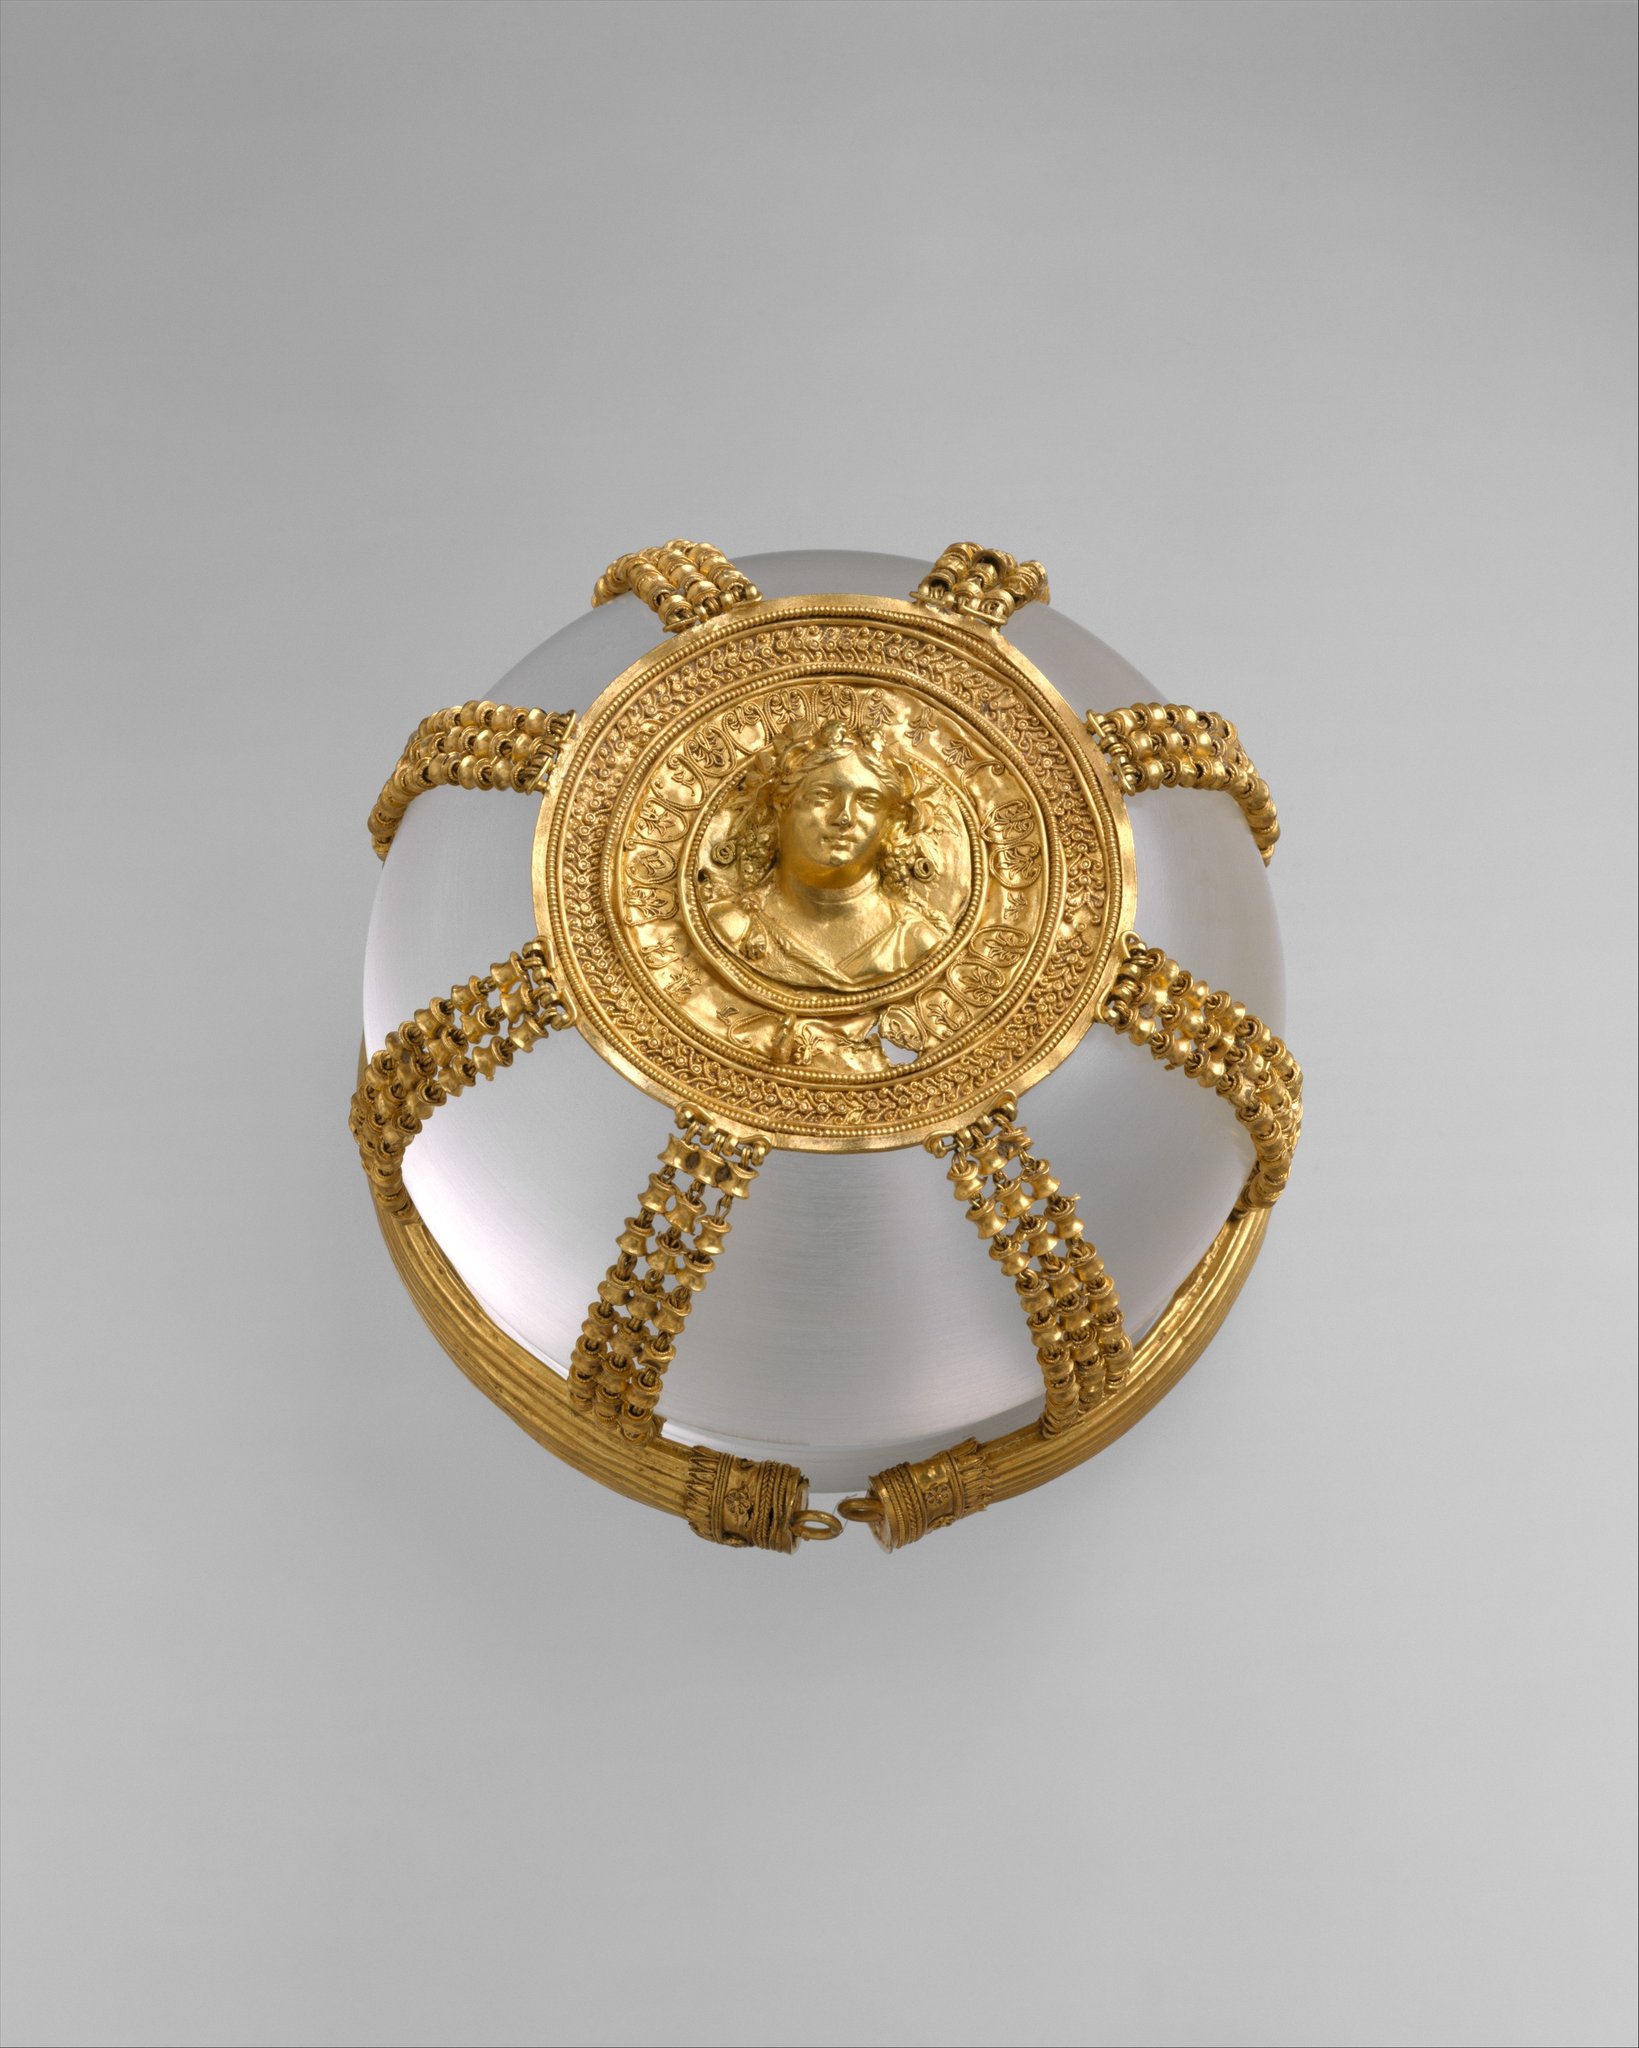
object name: hair ornament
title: Gold openwork hairnet with medallion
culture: greek, ptolemaic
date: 200-150 BCE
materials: gold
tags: women